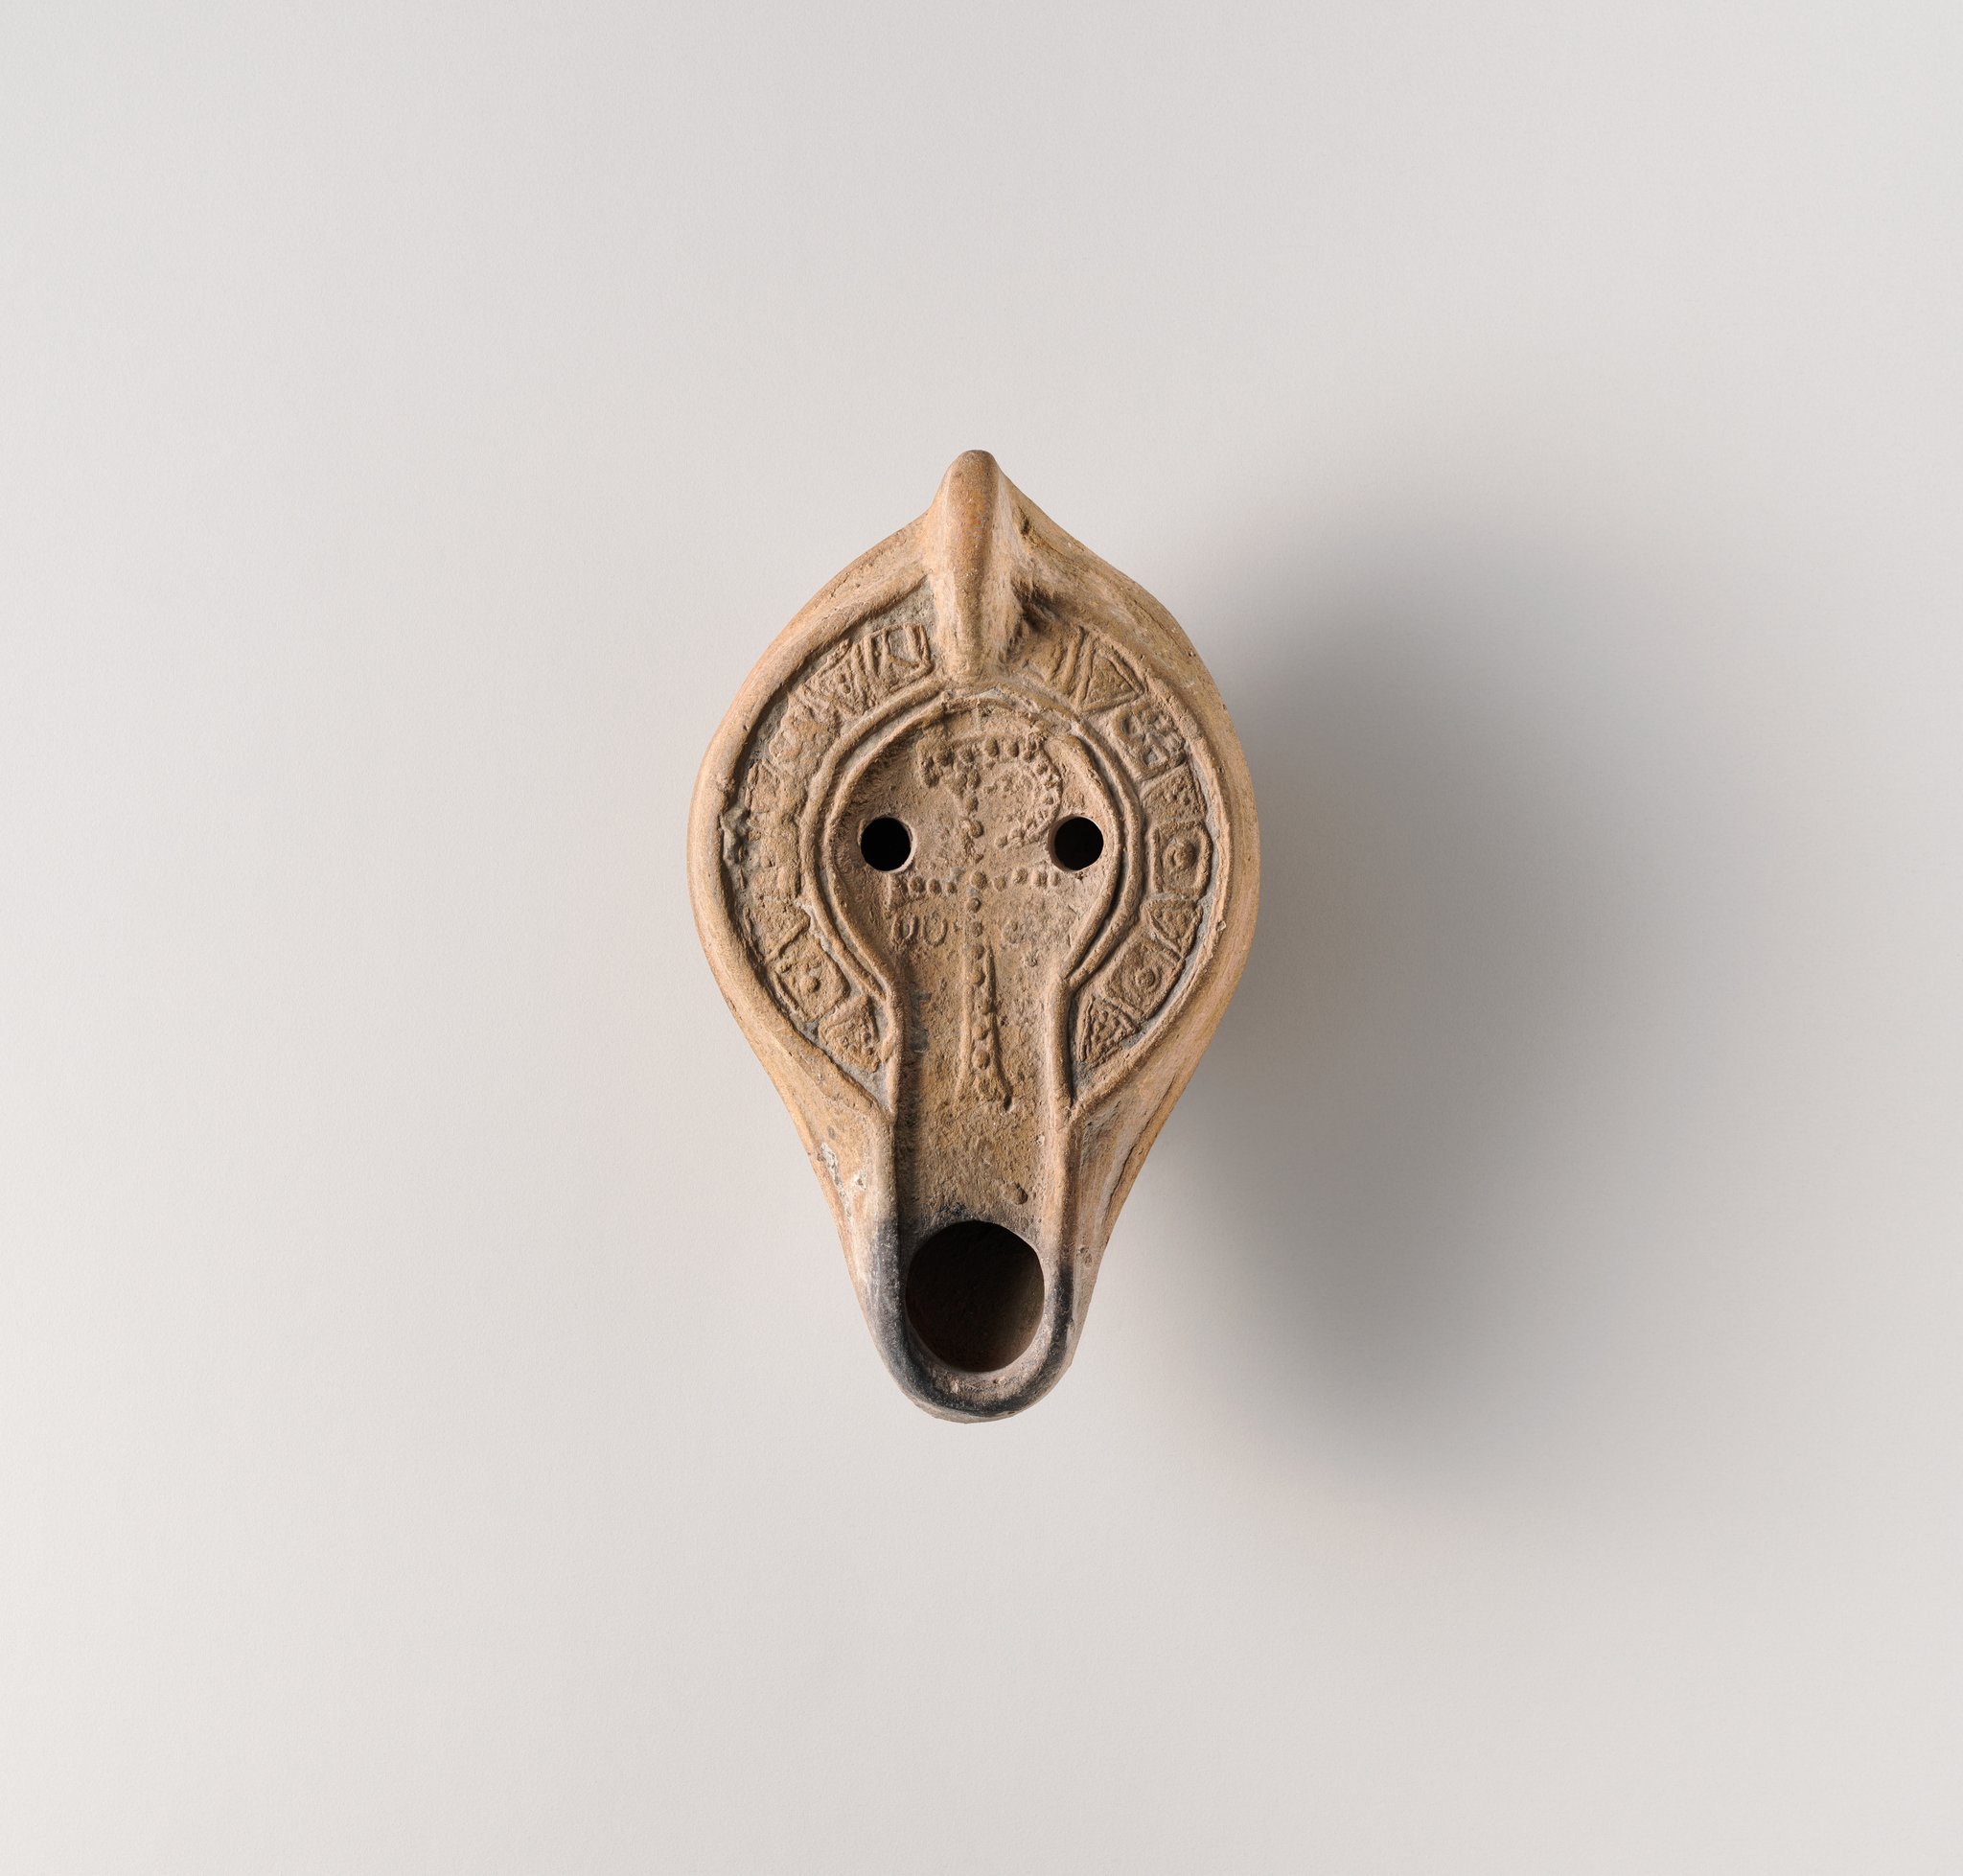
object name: lamp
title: Terracotta oil lamp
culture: roman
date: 401-500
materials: terracotta